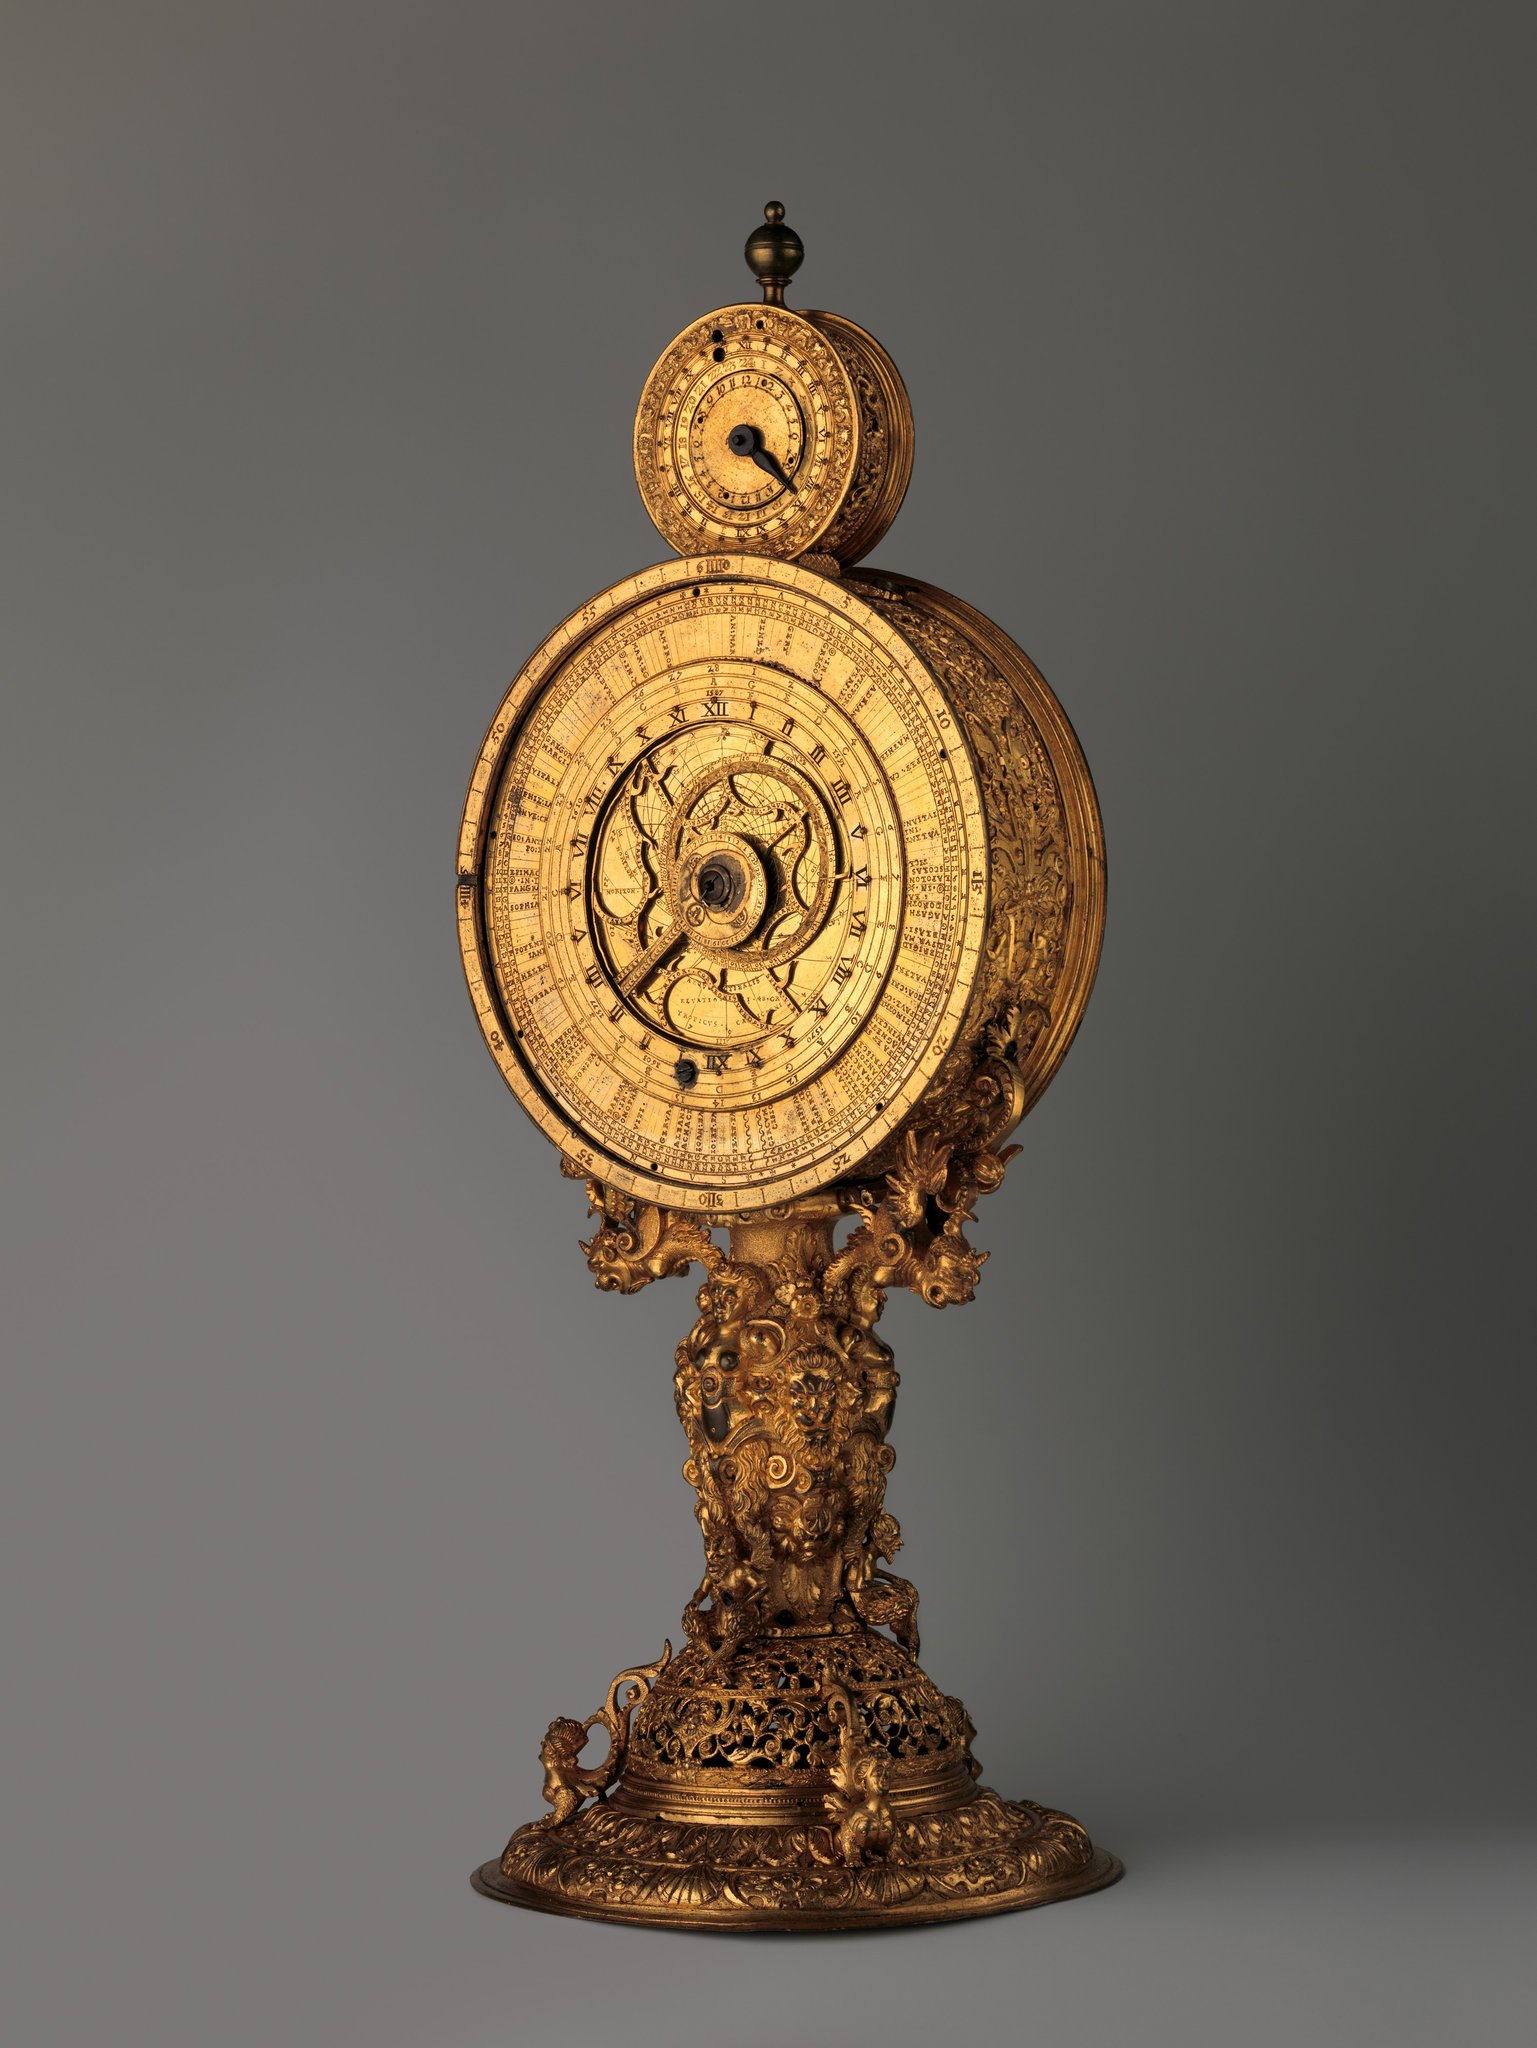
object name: mirror clock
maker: master cr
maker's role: maker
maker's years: -1565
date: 1565-1570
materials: gilt brass, gilt copper, iron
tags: dragons,sphinx,satyrs